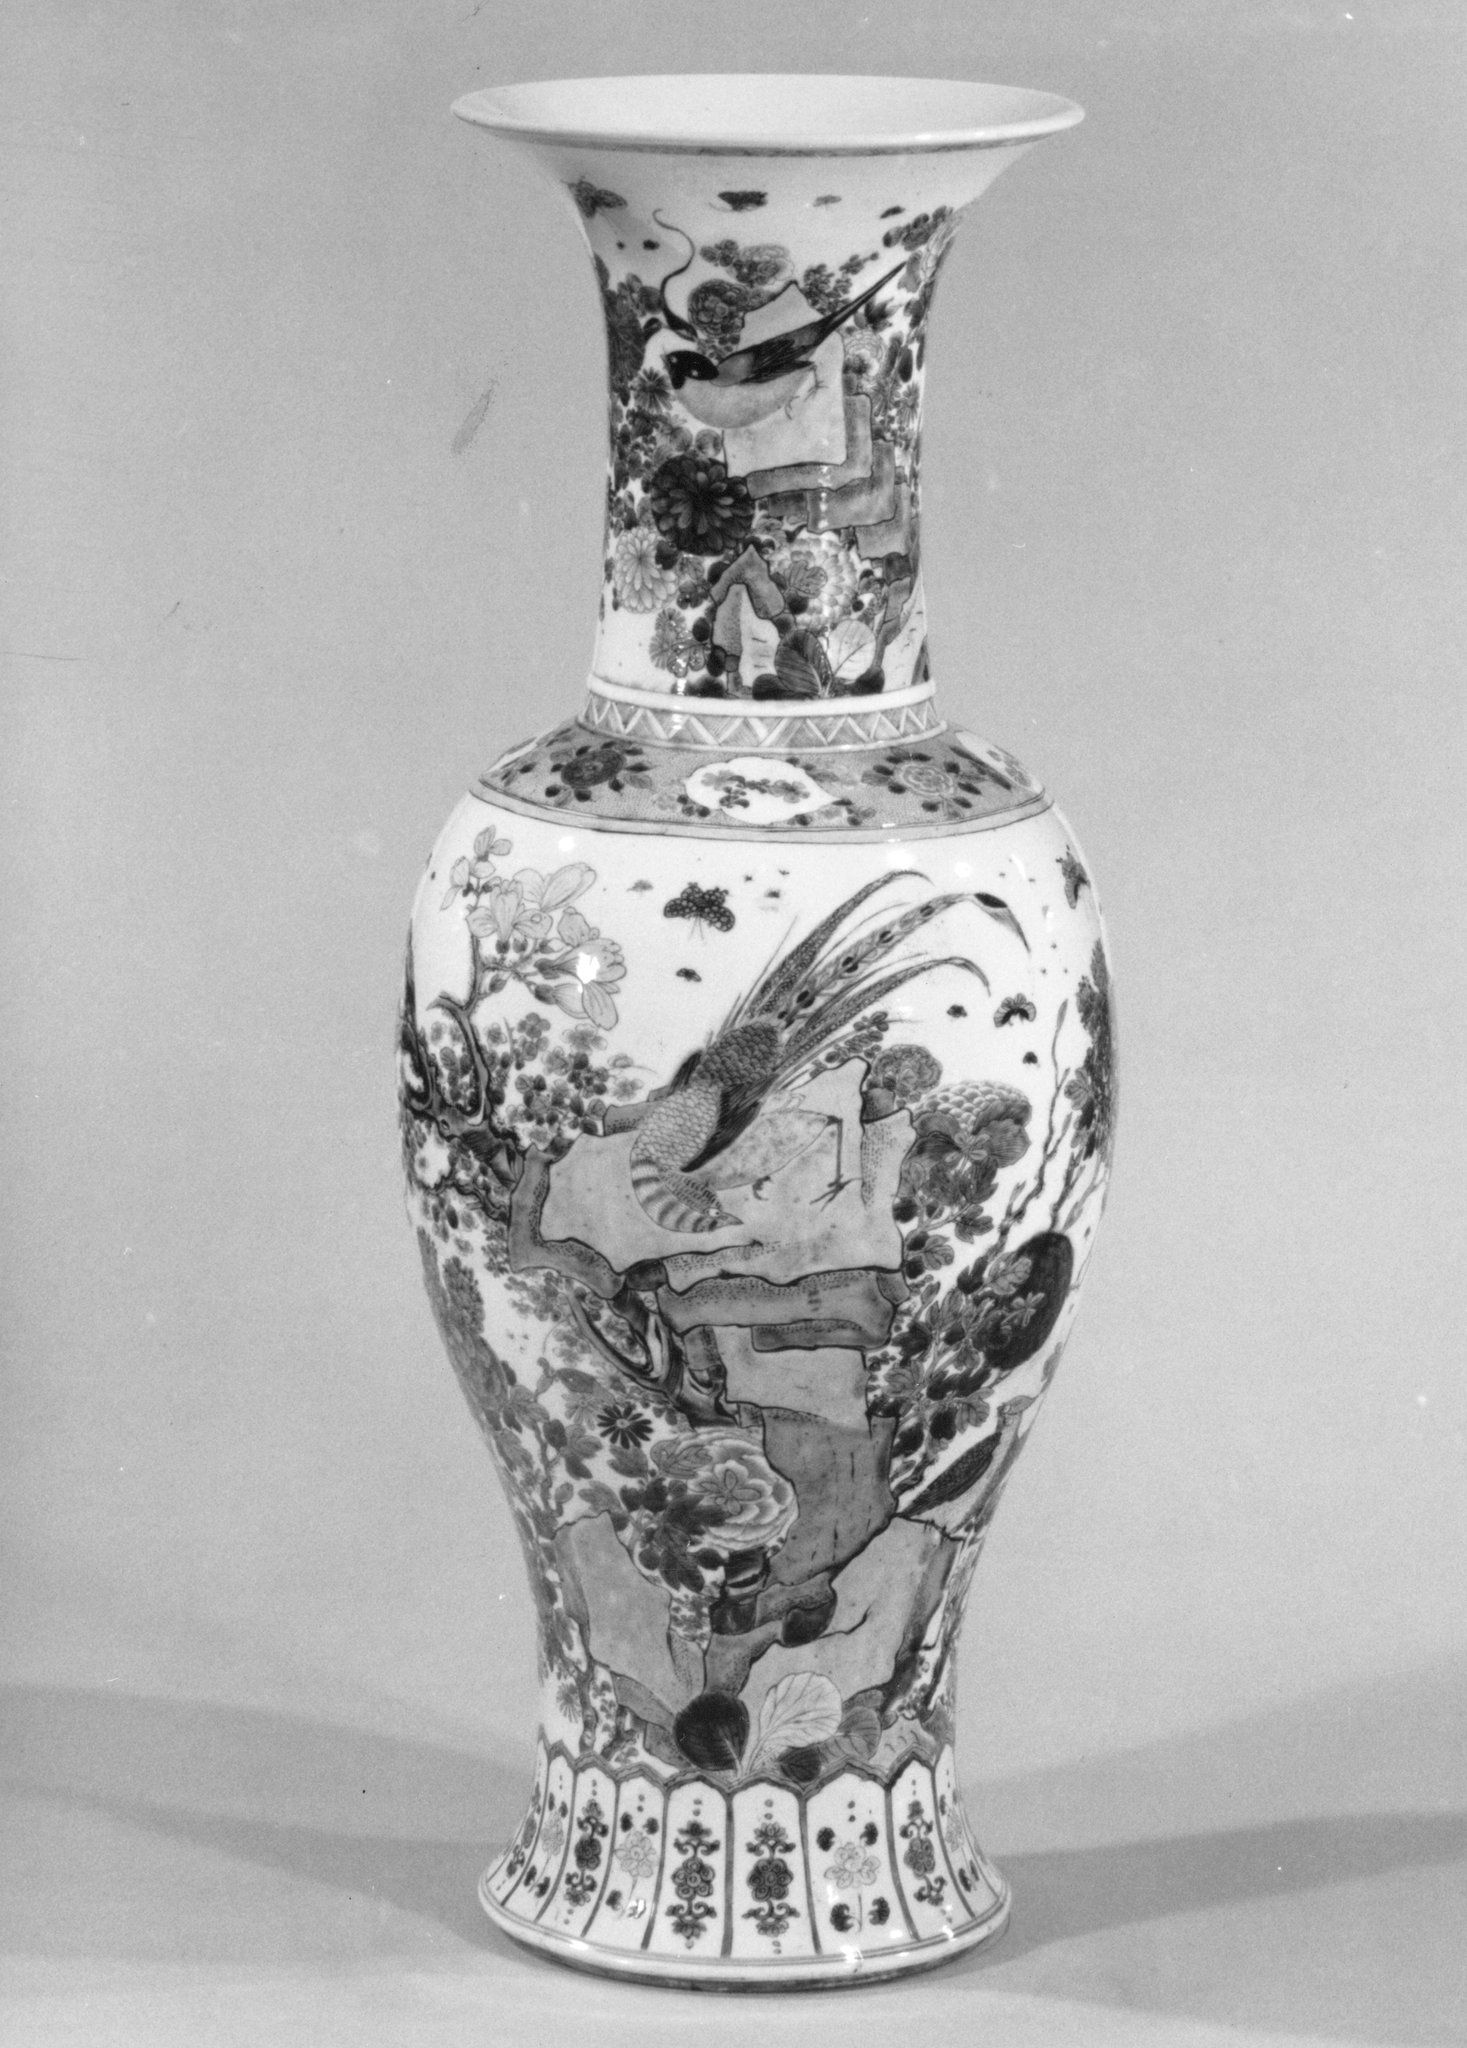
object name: vase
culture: chinese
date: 1662-1722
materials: enamel, gold, porcelain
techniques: painting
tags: birds,butterflies